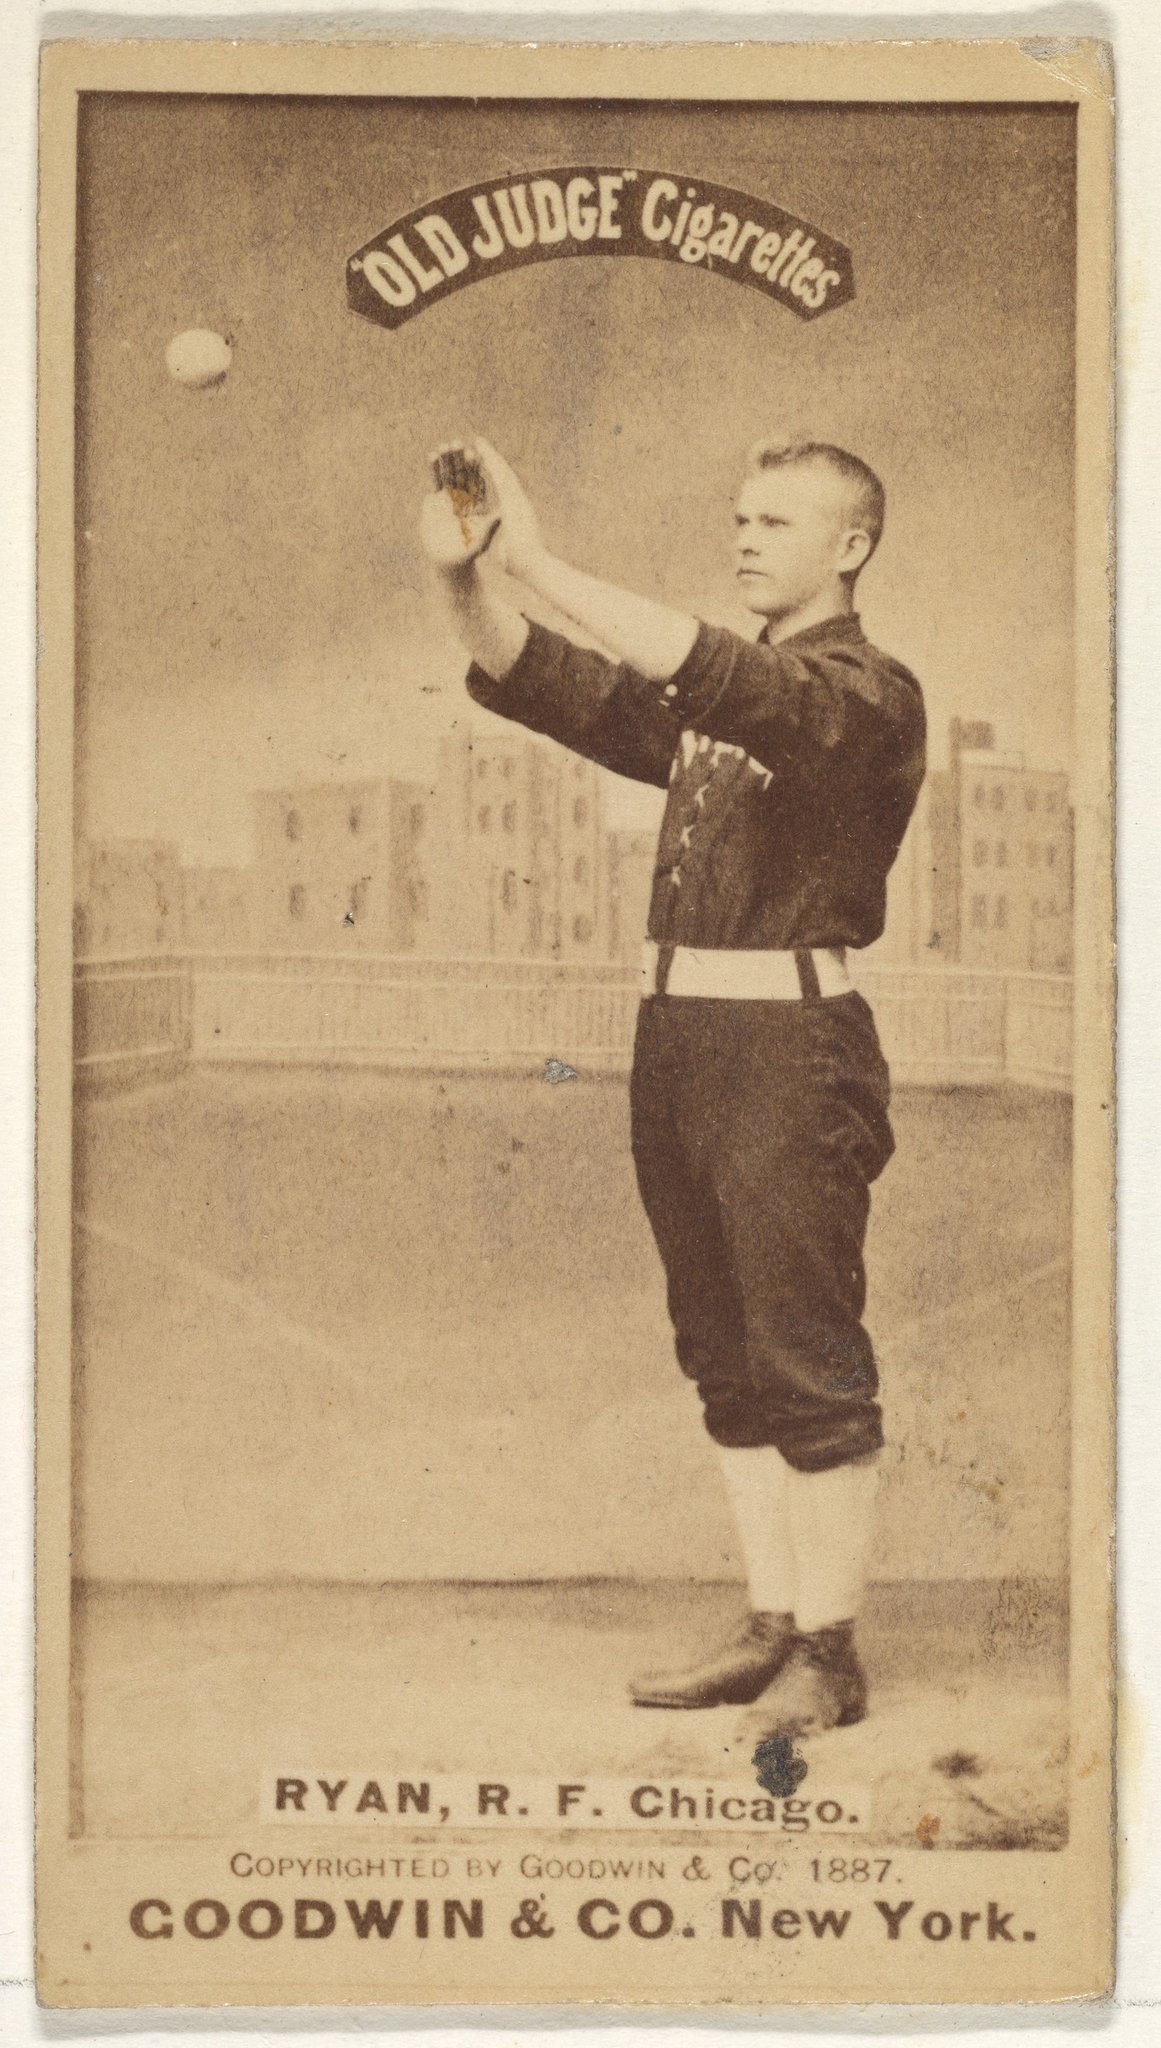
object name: baseball card, photograph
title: Ryan, Right Field, Chicago, from the Old Judge series (N172) for Old Judge Cigarettes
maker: goodwin & company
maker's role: publisher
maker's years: 1850-1950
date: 1887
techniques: albumen silver print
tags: men,portraits,baseball,athletes